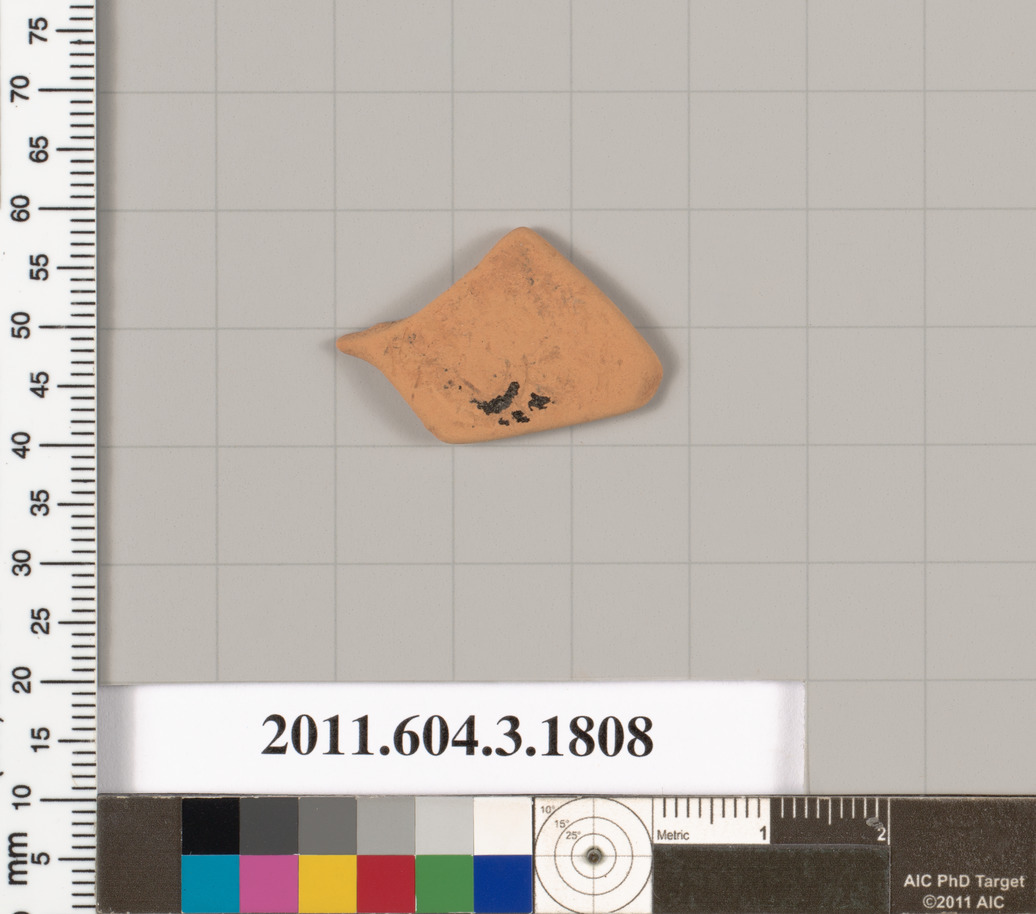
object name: kylix fragment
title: Terracotta fragment of a kylix: Lip cup (drinking cup)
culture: greek, attic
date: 550-526 BCE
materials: terracotta